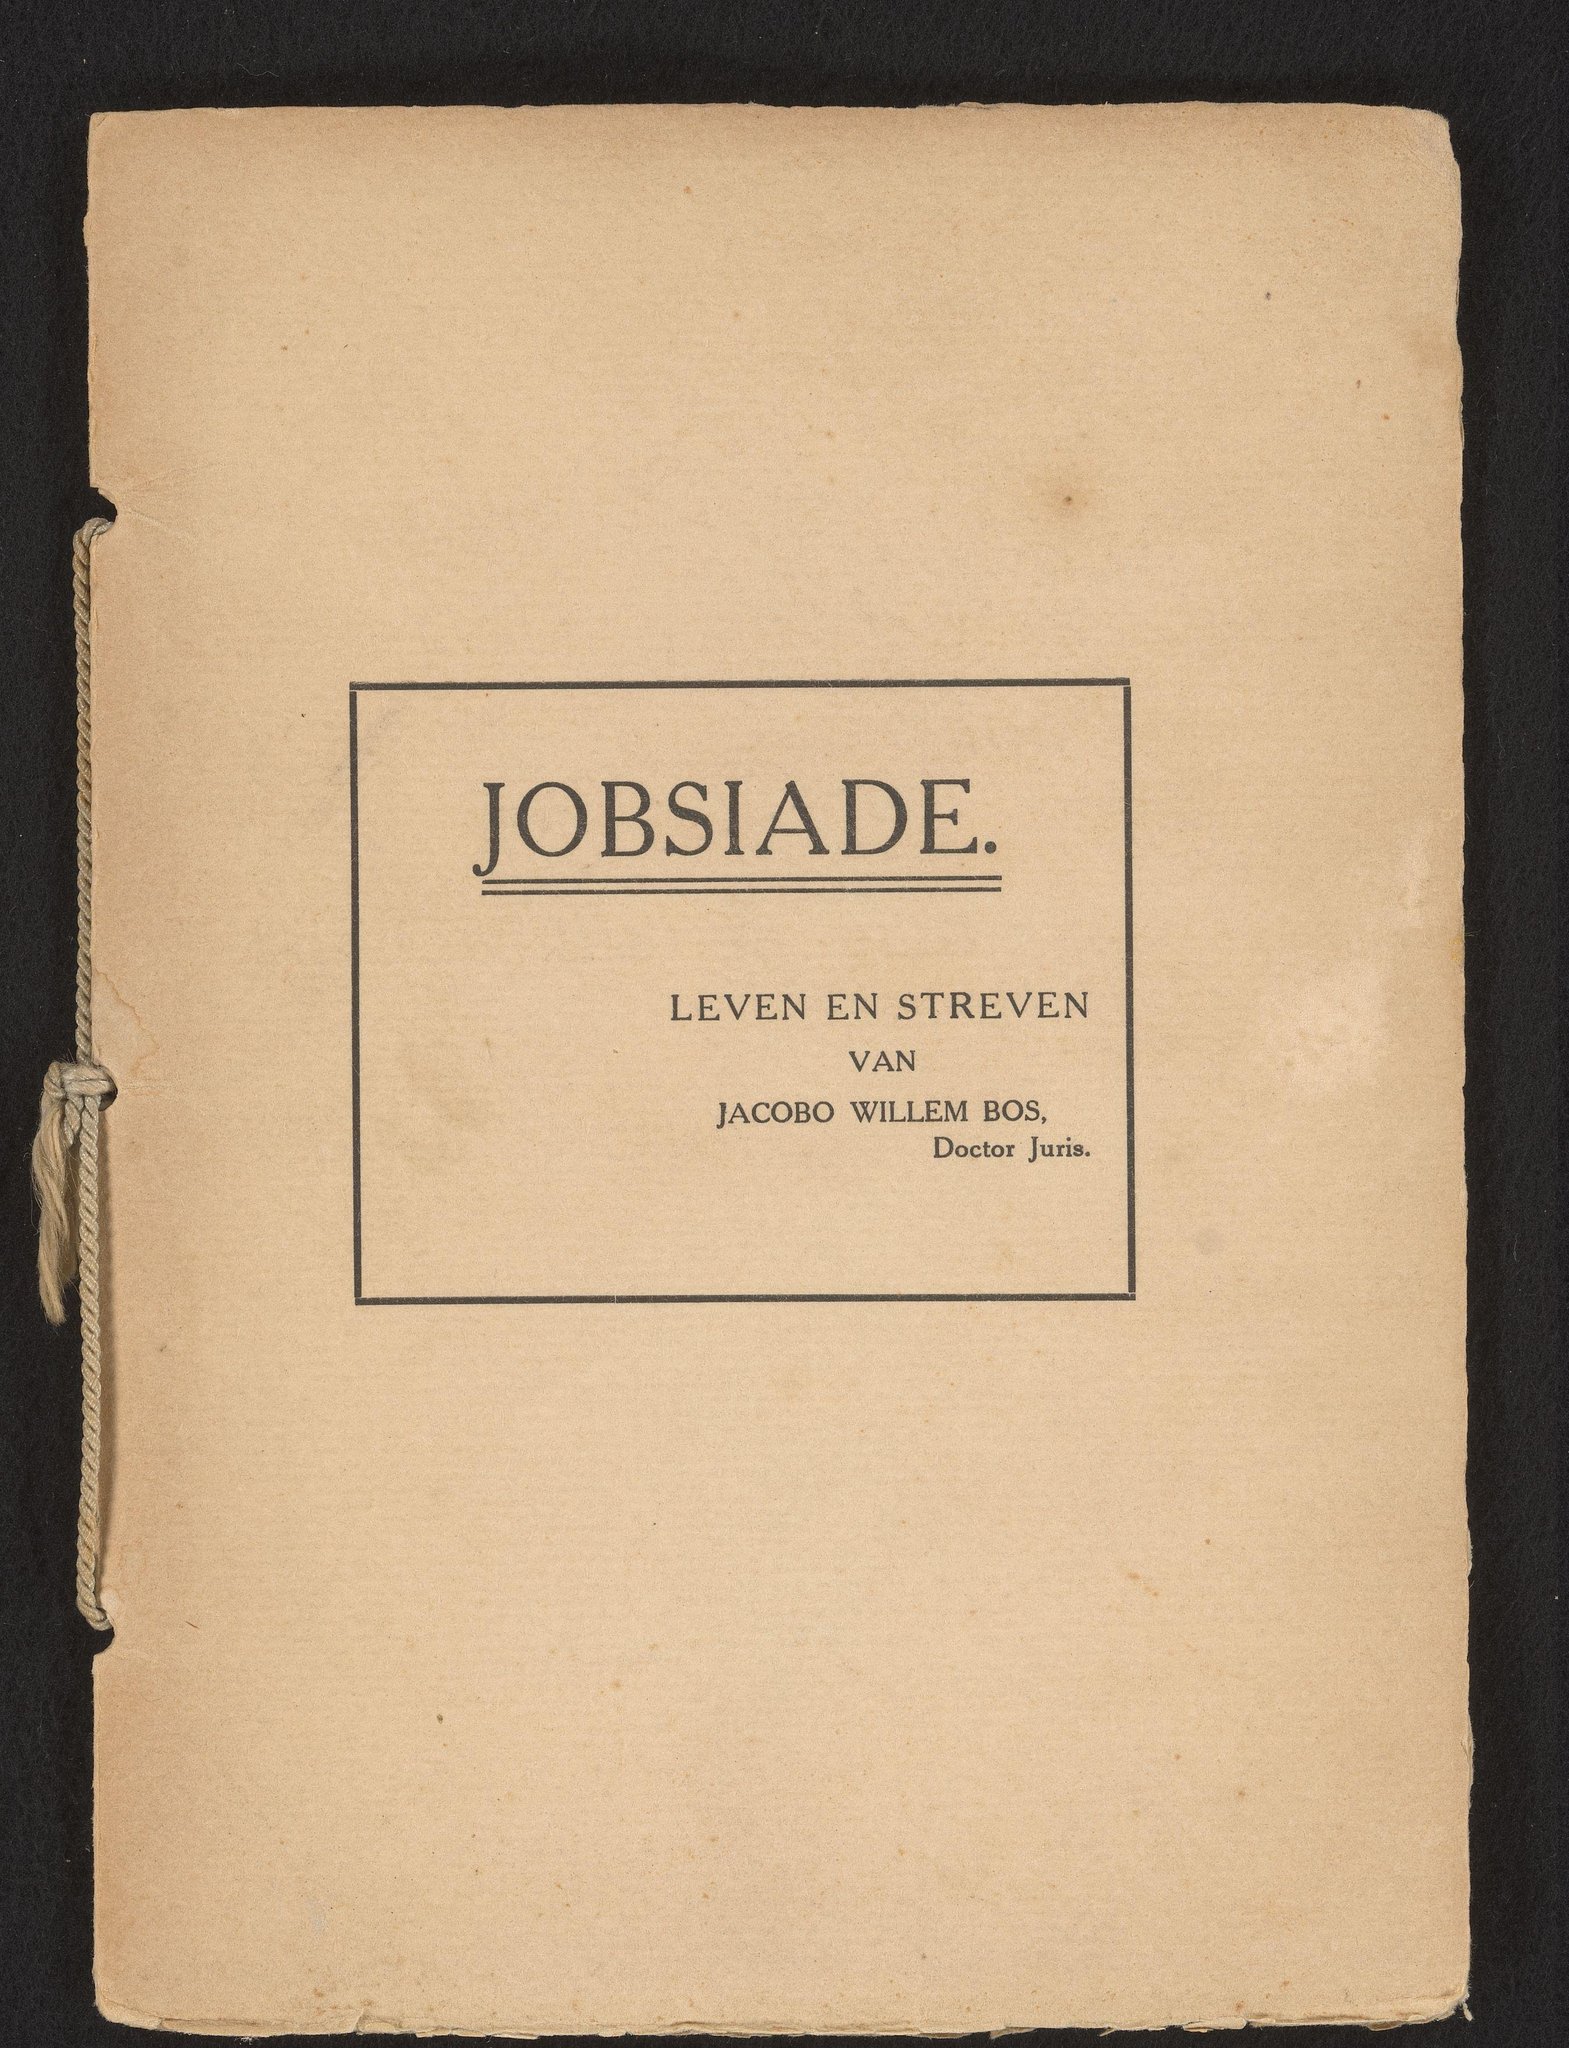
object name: book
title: Jobsiade : leven en streven van Jacobo Willem Bos, Doctor Juris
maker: Anonymous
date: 1920-1925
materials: paper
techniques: gelatin silver print, letterpress printing